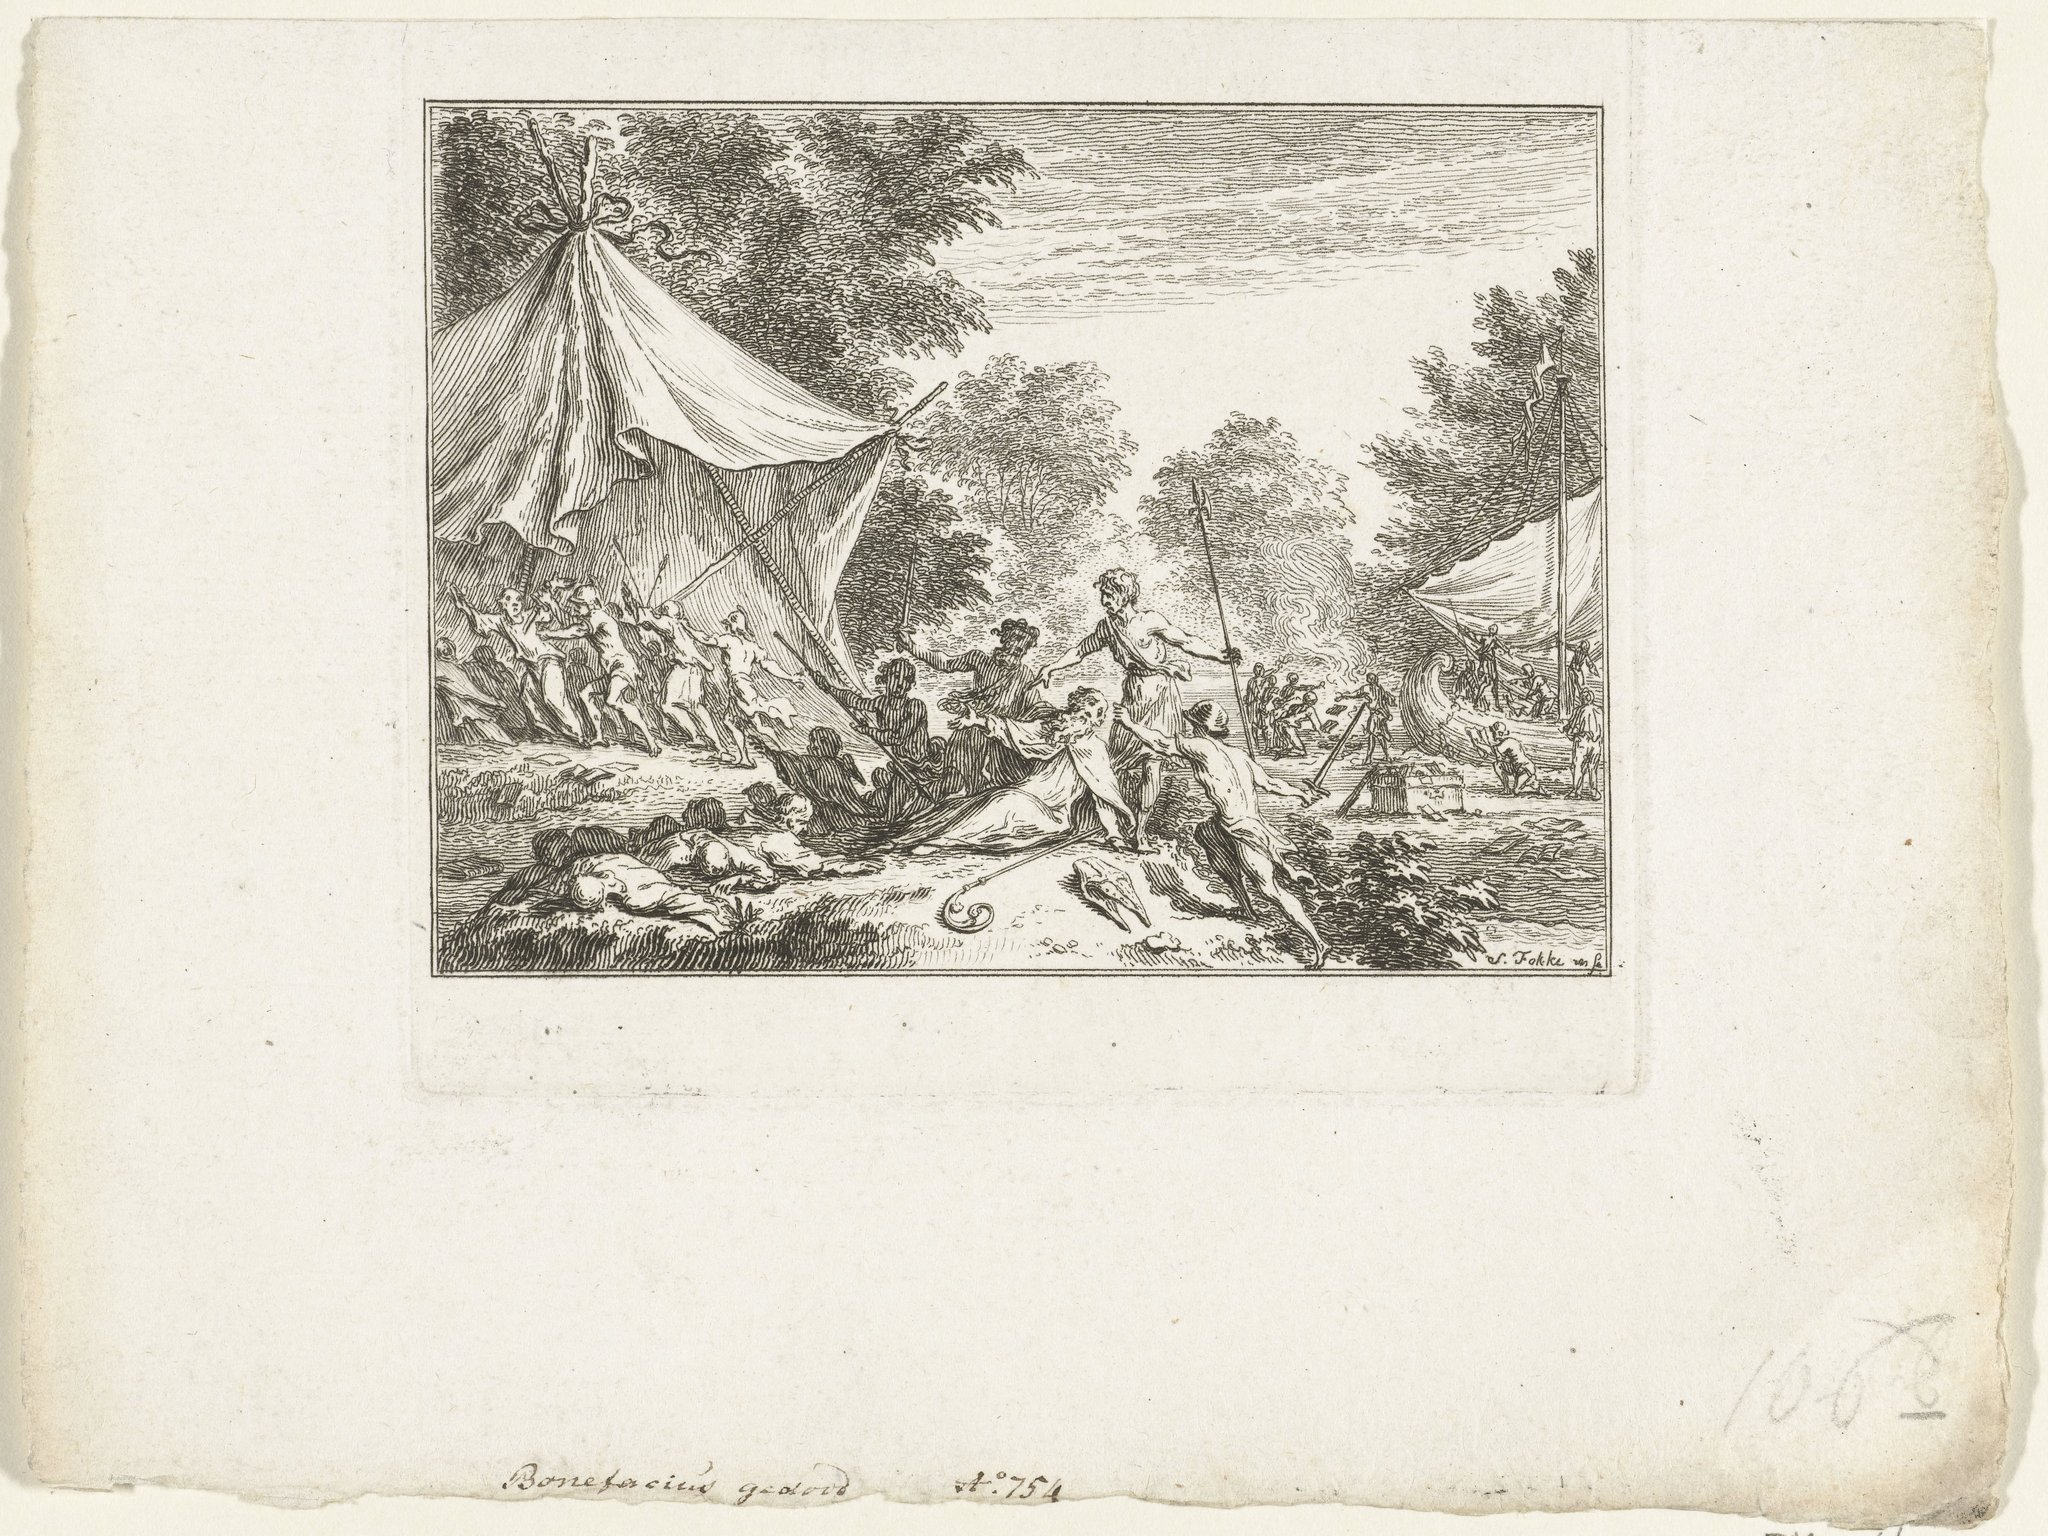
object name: print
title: Bonifatius bij Dokkum vermoord, 754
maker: simon fokke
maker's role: draughtsman, print maker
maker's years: 1712-1784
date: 1722-1750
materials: paper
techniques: etching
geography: northern netherlands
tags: martyrdom, suffering, misfortune, death of st. boniface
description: Illustratie voor een onbekend werk, later hergebruikt in: J.W. te Water, De vaderlandsche Historie van den heere J. Wagenaar, verkort, en met leerzaame aanmerkingen, ten dienste der Nederlandsche jeugd, 1784-1800, 4 delen. Pl. VII, blz. 88. Staat vóór de letter.